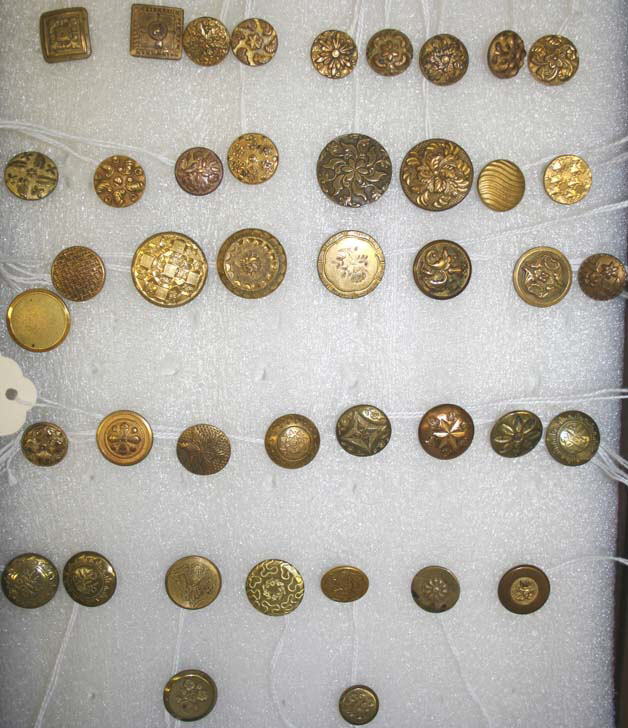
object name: button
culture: american or european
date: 1830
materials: metal